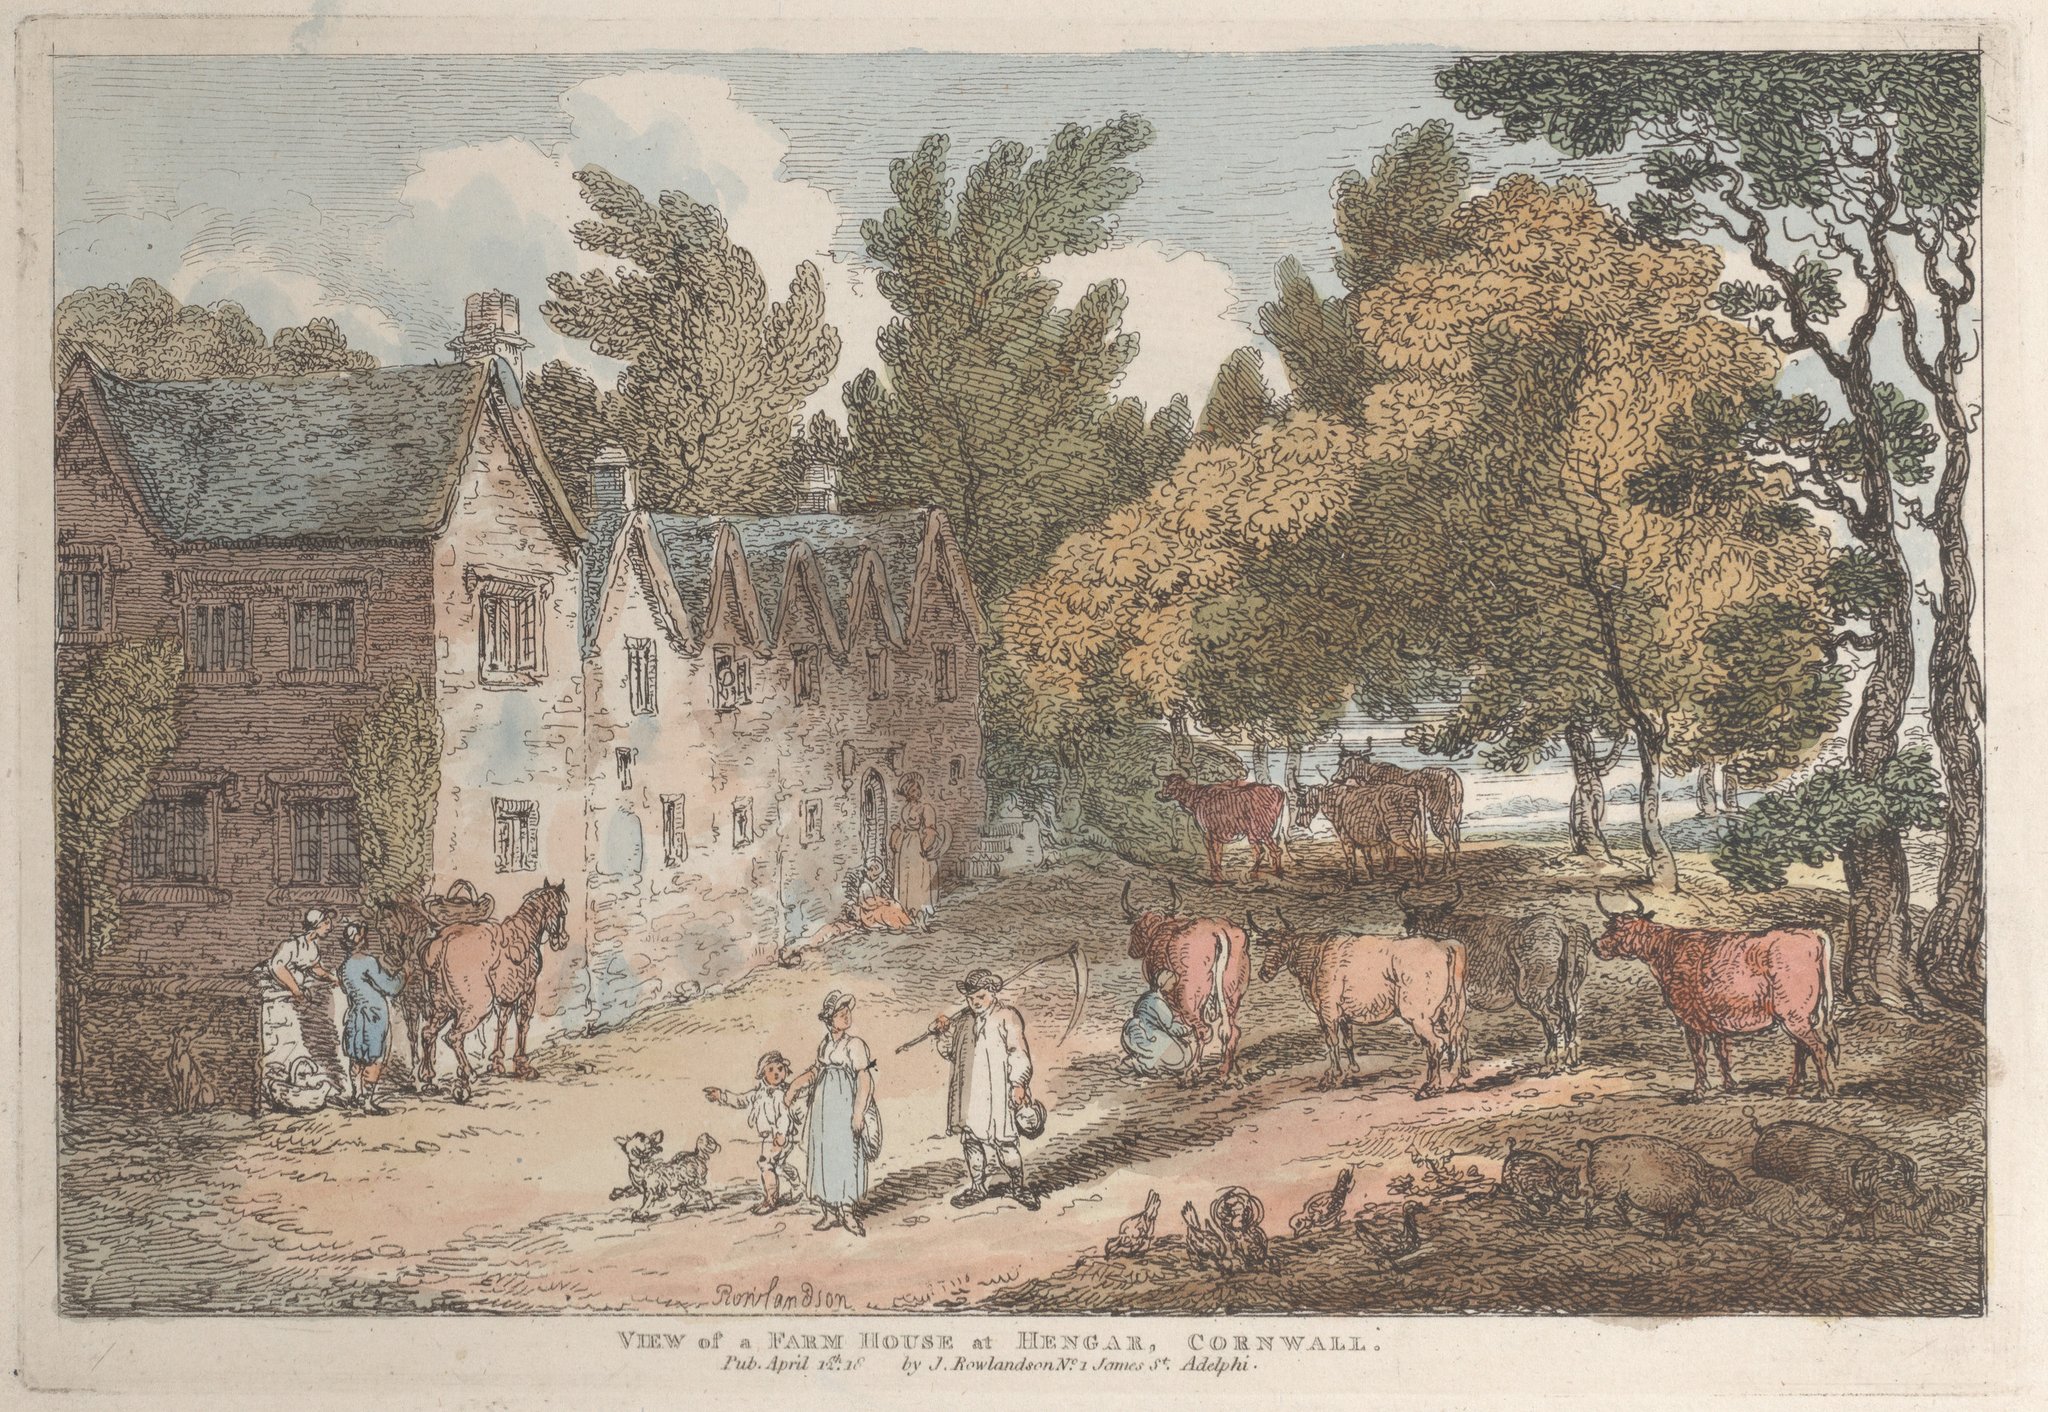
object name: print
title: View of a Farm House at Hengar, Cornwall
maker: thomas rowlandson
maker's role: artist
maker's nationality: british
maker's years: 1757-1827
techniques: etching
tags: houses,cows,horses